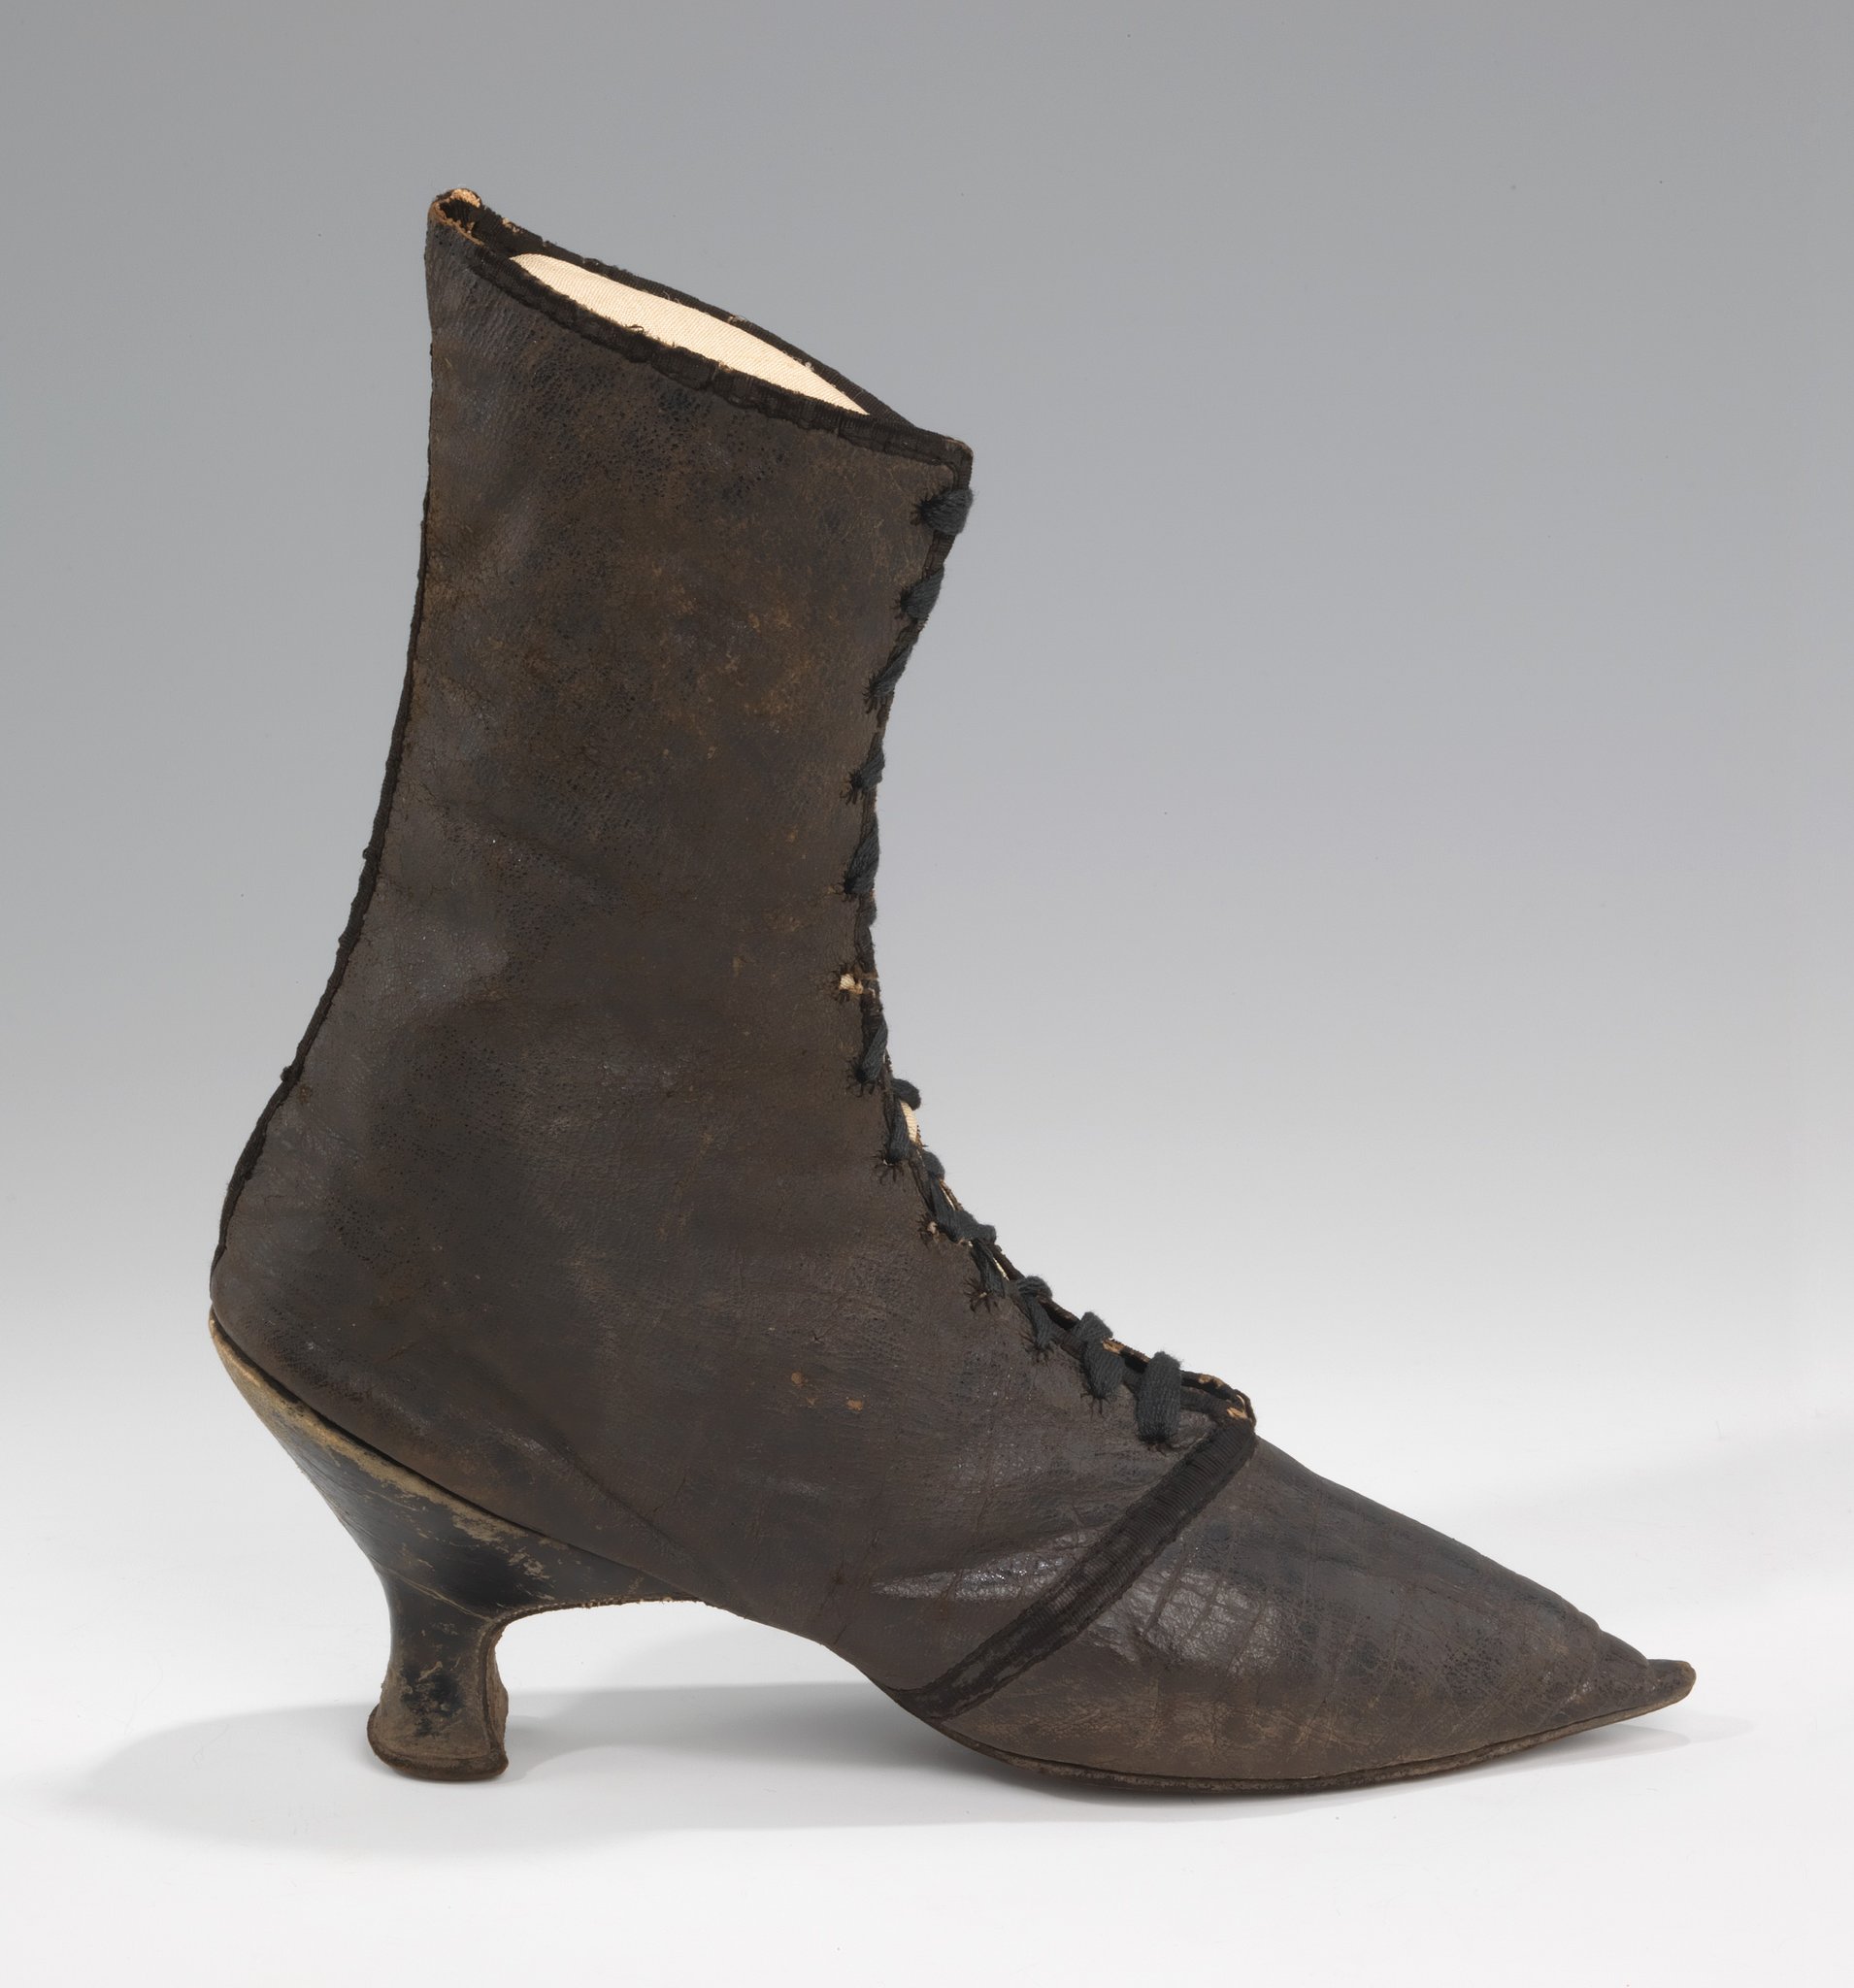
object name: boot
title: Boots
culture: european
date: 1780-1795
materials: leather